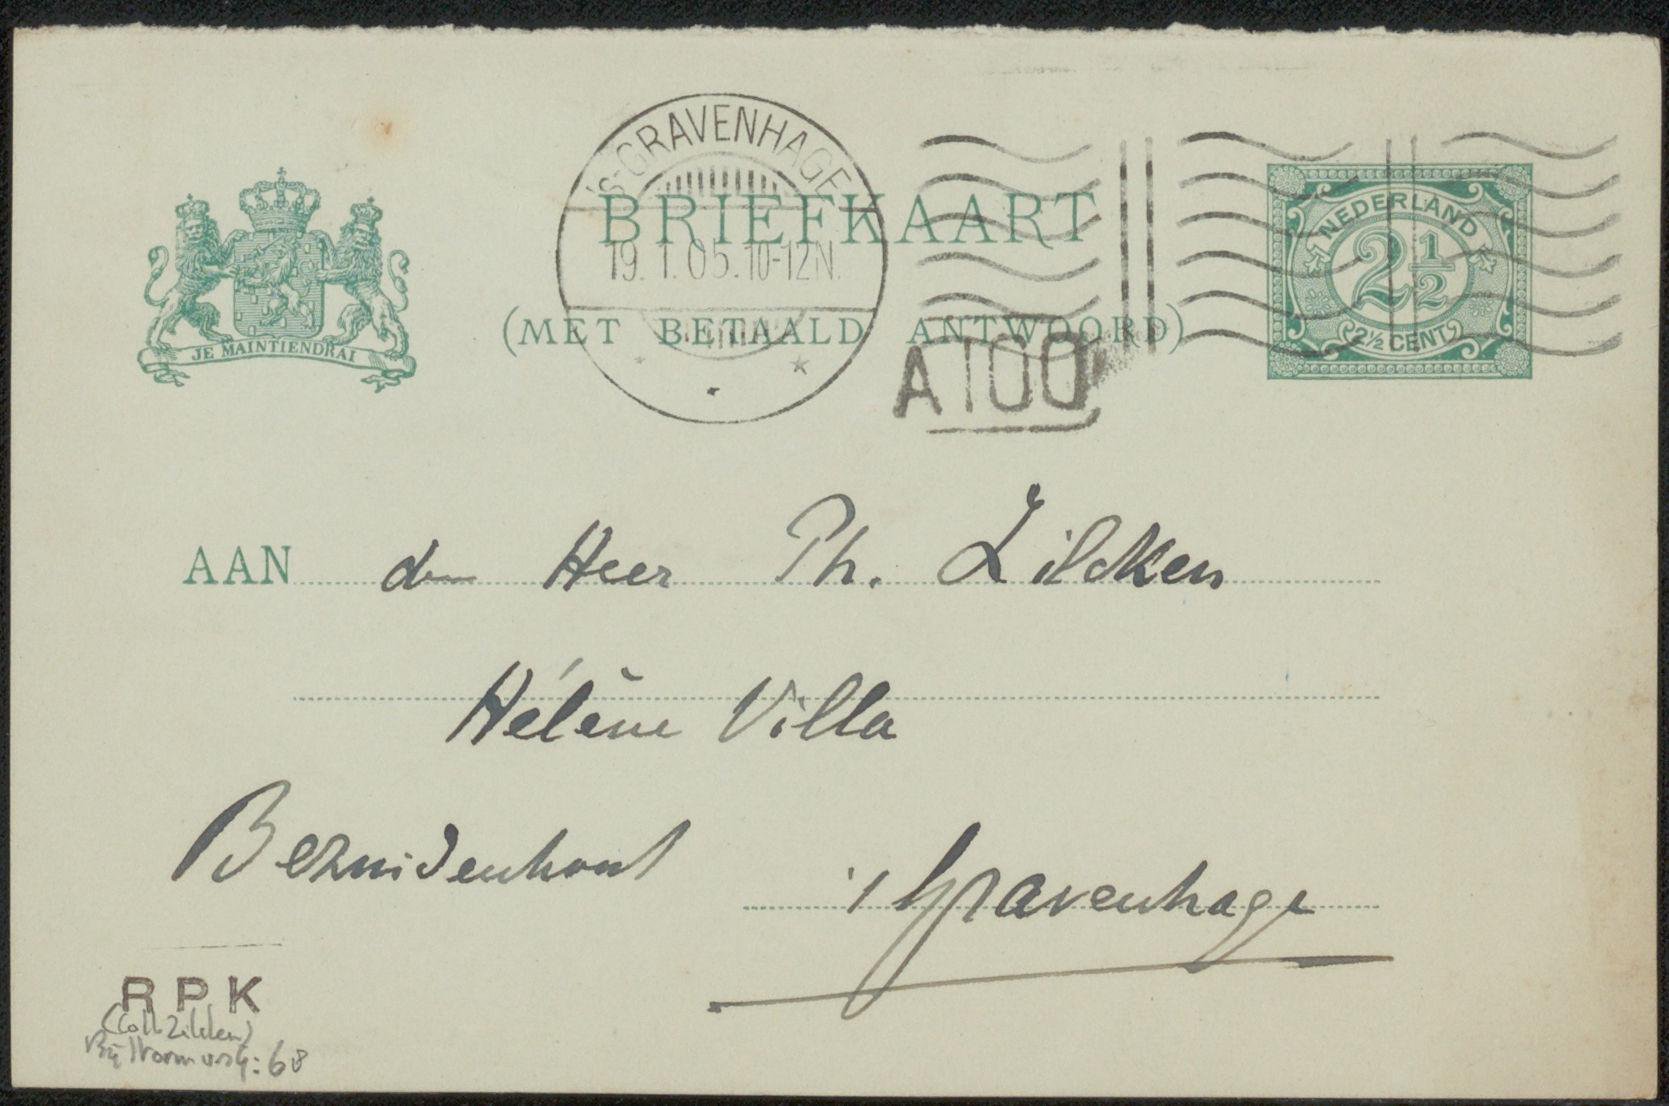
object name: postcard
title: Briefkaart aan Philip Zilcken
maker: carel nicolaas storm van s-gravesande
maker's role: draughtsman, print maker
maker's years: 1841-1924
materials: cardboard, ink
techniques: pen, writing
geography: the hague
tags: painter, philip zilcken, the graphic arts, exhibition ~ art, venice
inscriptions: watermark, collector's mark: ‘RPK’